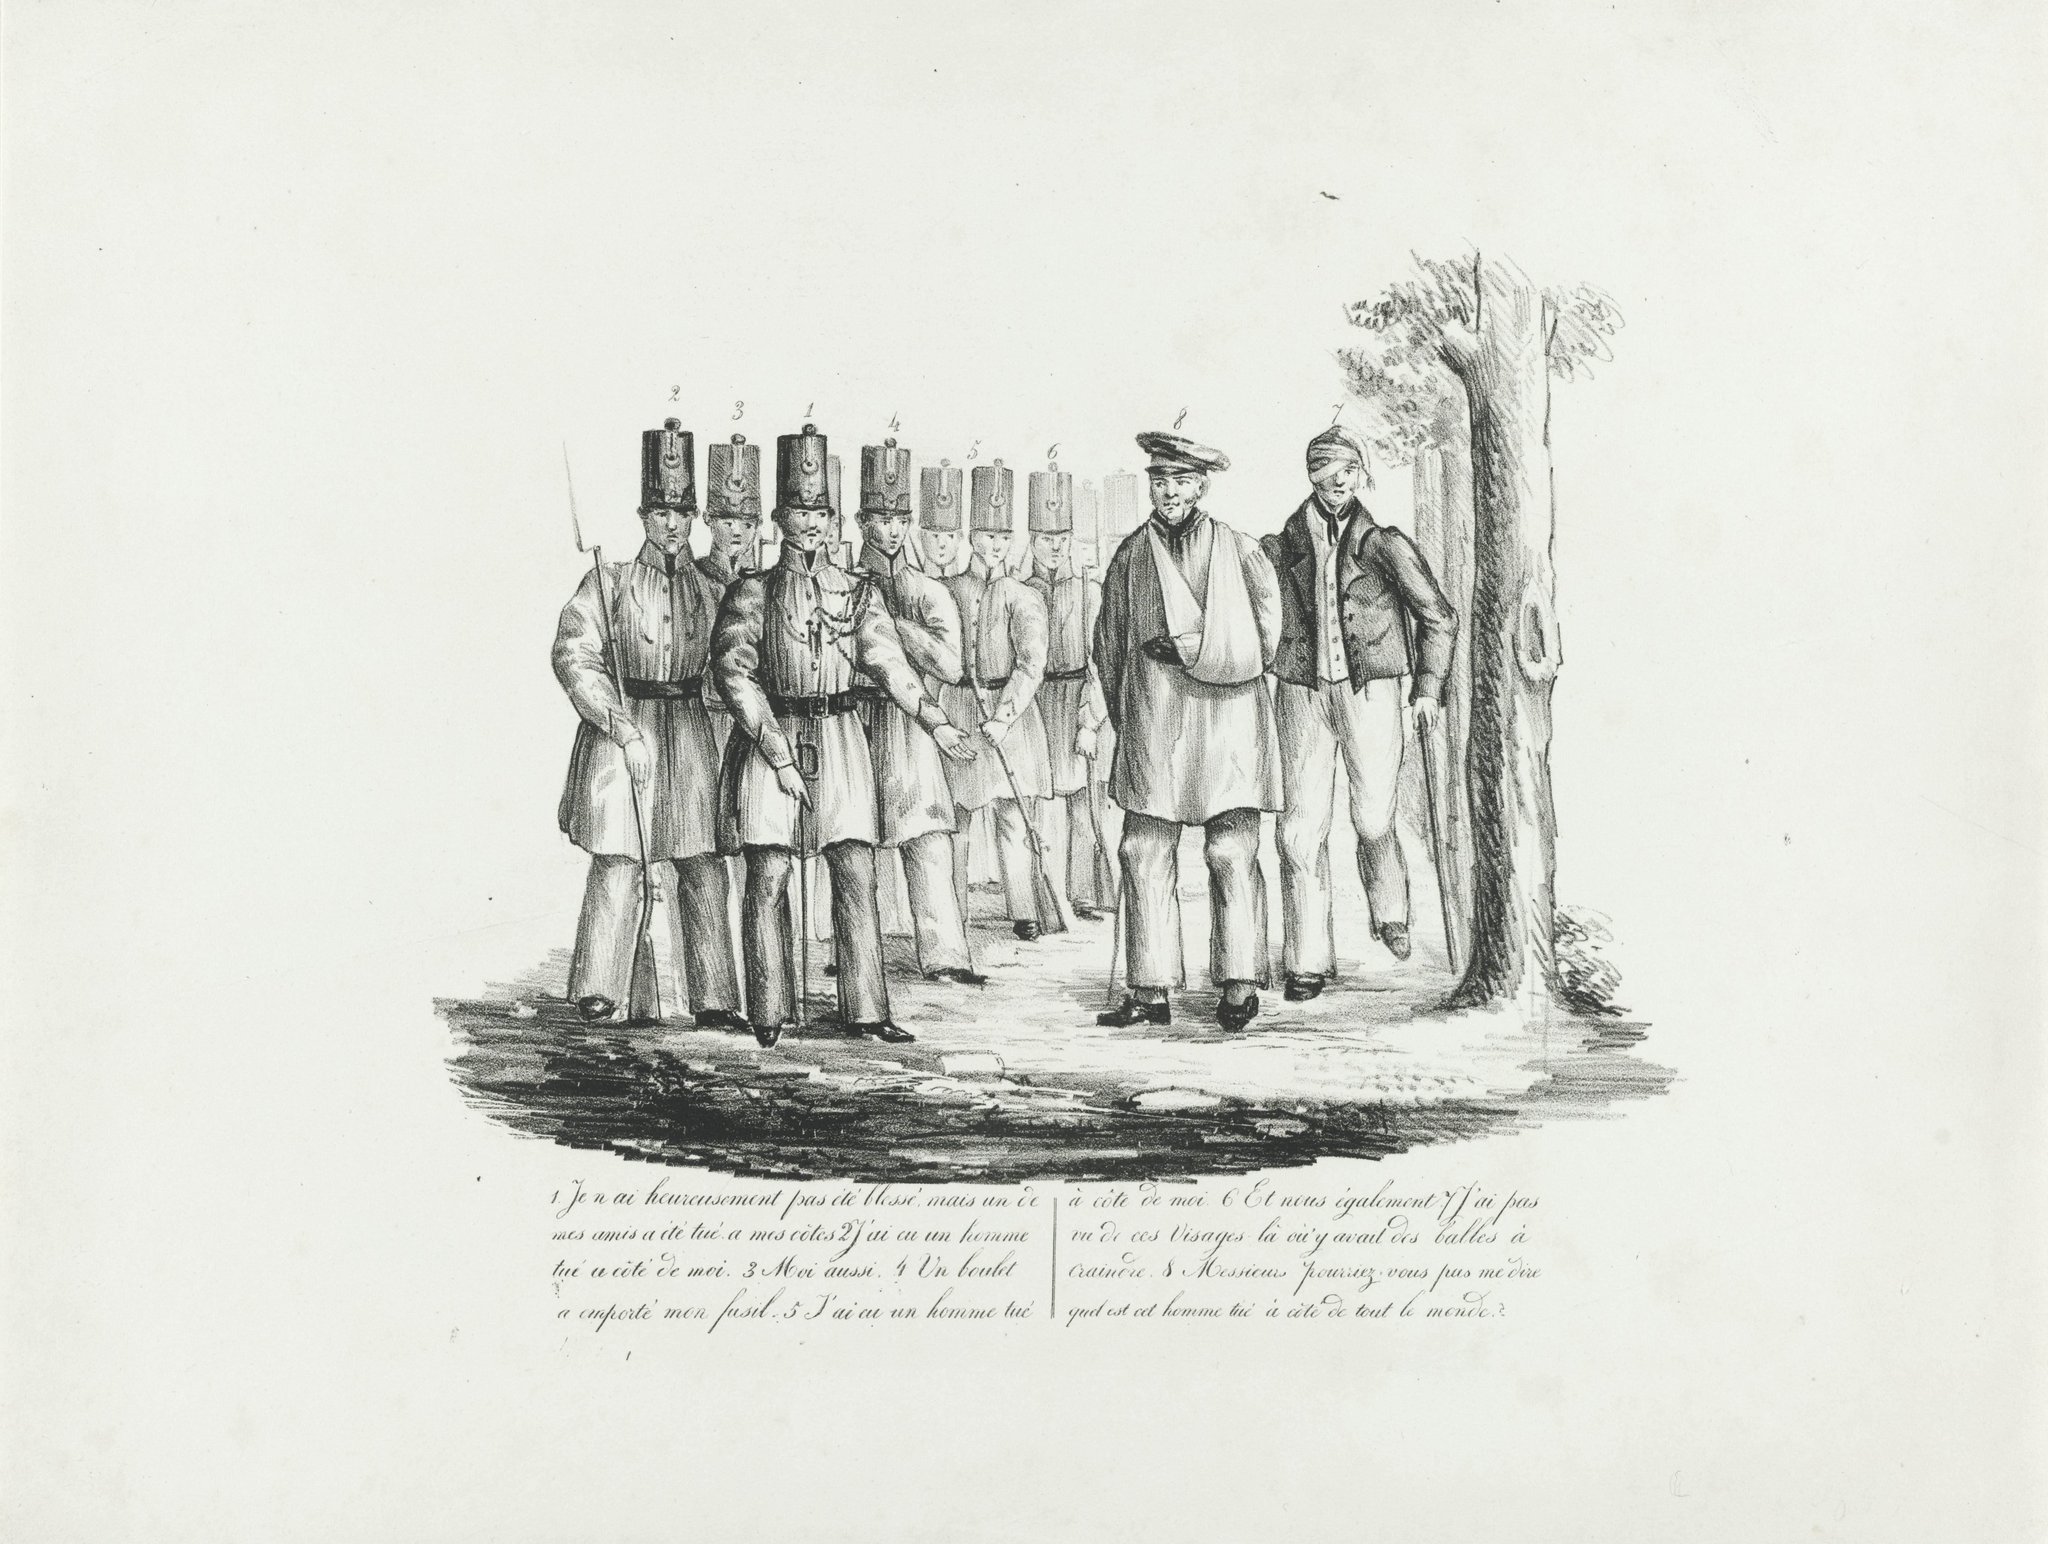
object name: print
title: Spotprent op de Belgische lafhartigheid, 1831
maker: Anonymous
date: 1831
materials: paper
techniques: lithograph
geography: netherlands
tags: london, willem iv hendrik (koning van het verenigd koninkrijk en hannover), disabled soldier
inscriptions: collector's mark: Lugt 2228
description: Spotprent op de Belgische lafhartigheid, 1831. Twee gewonde Nederlandse soldaten passeren een groep Belgische militairen. Met onderschrift in twee keer vier regels, met de nummers 1-8.